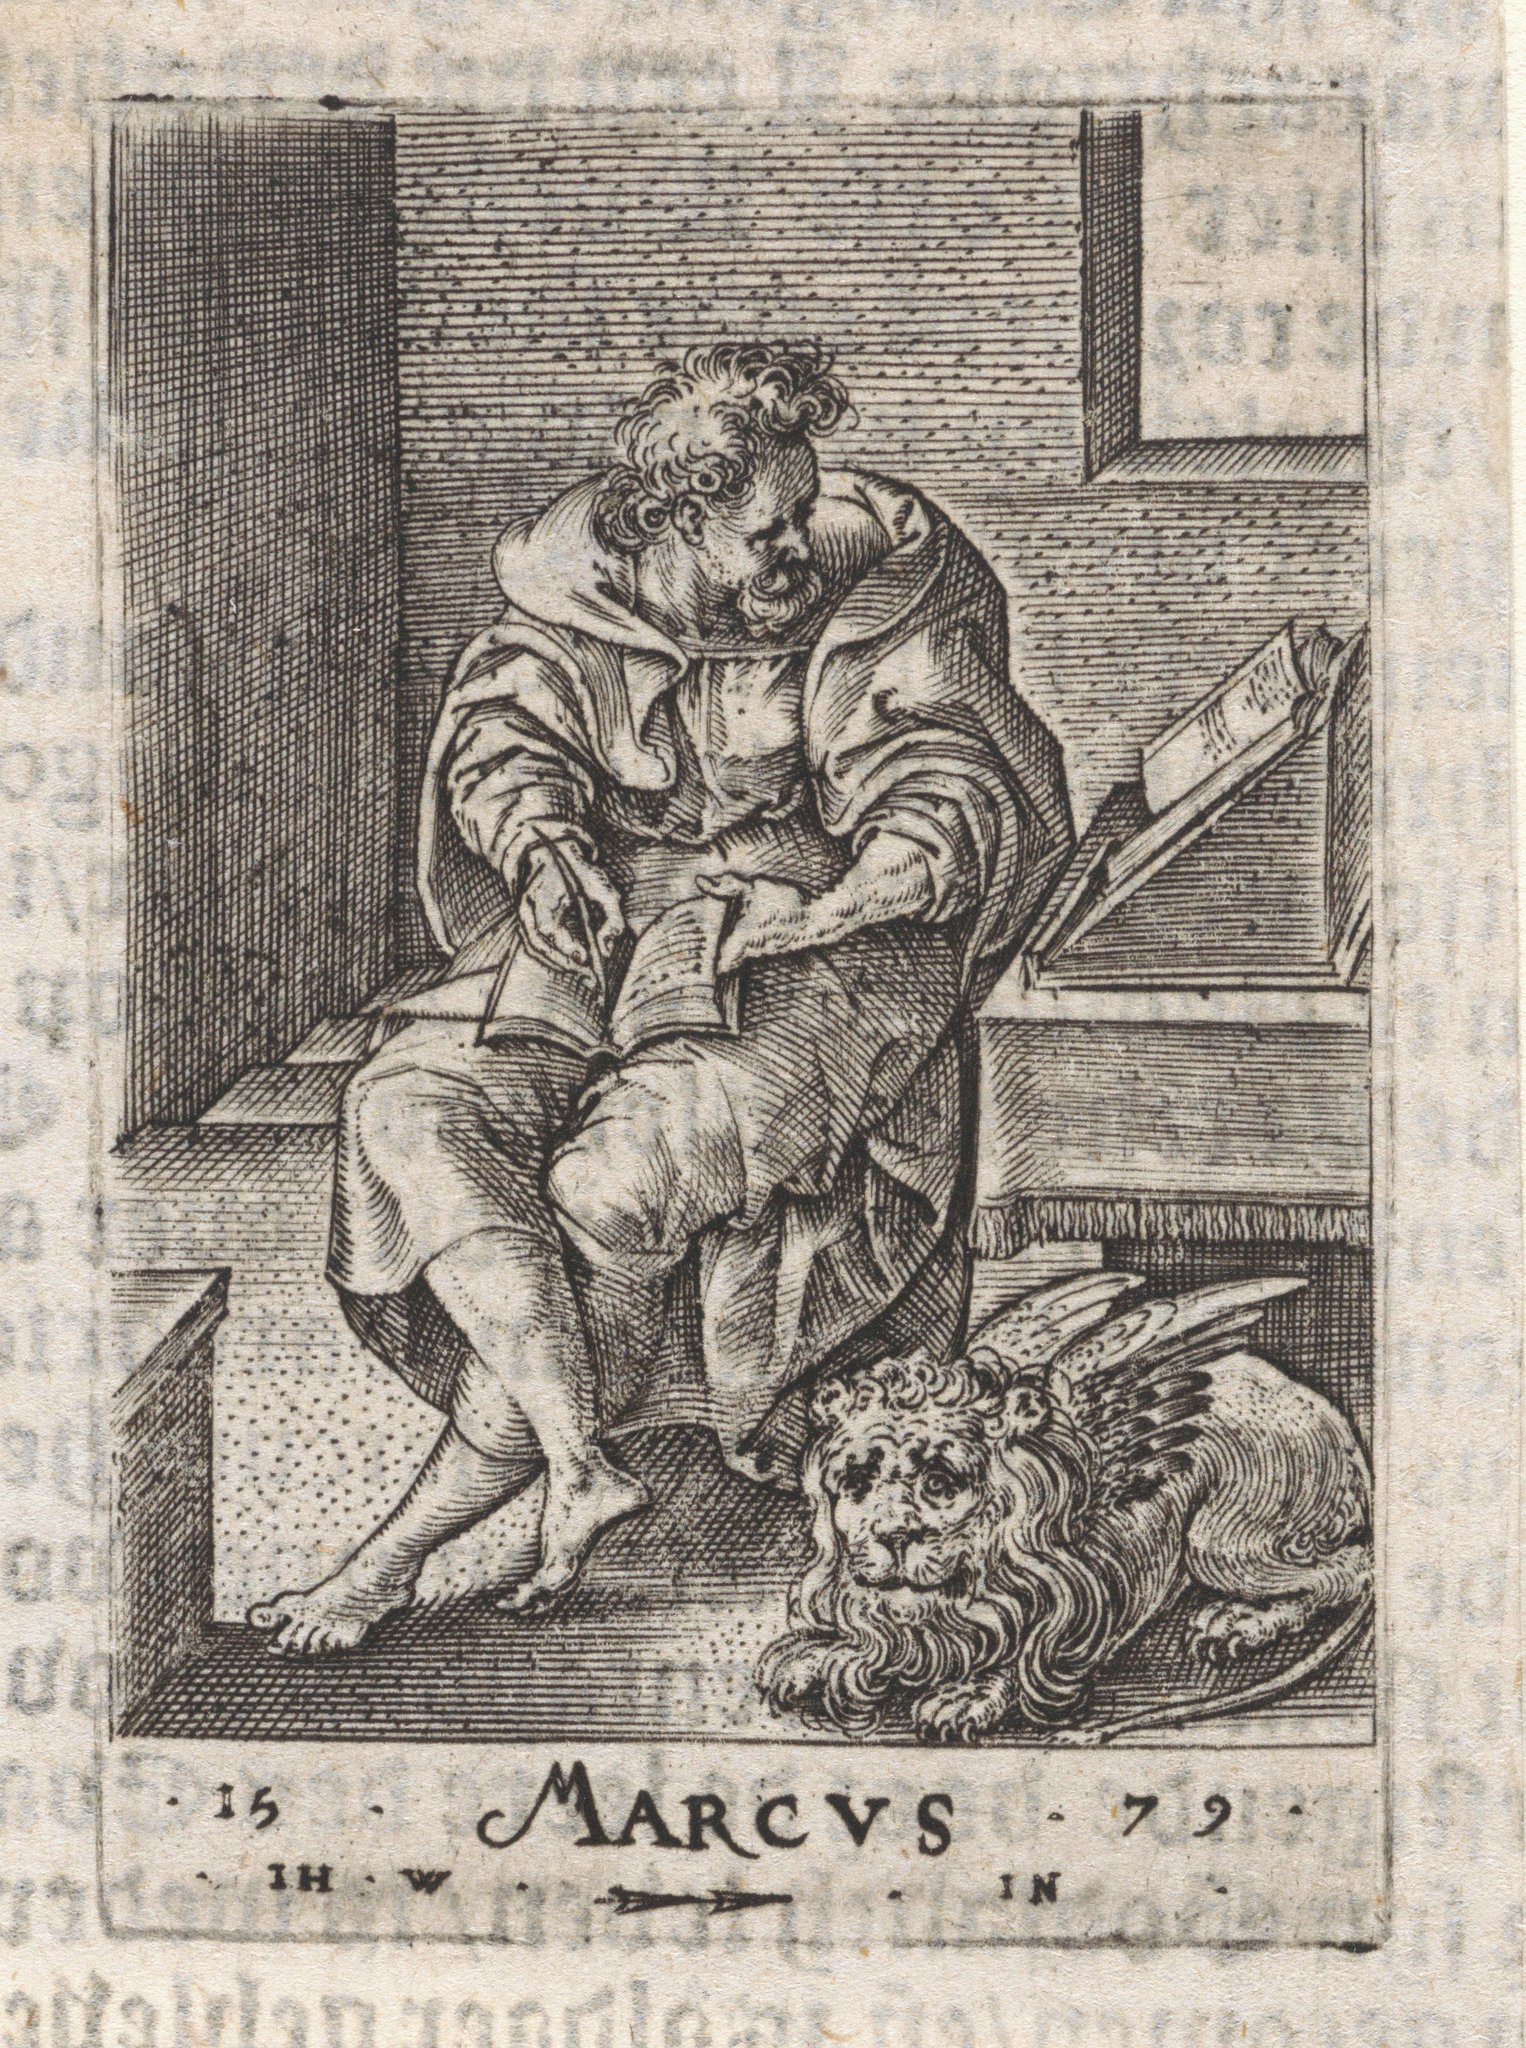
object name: book illustration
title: Vier evangelisten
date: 1579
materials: paper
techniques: engraving, letterpress printing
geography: delft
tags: st. mark the evangelist writing the gospel, usually a (winged) lion present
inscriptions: collector's mark: Lugt 2228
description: Prent gebruikt als illustratie in: Const-toonneel, inhoudende de beschrijvinghe ende XL. Heerlijcke afbeeldindinghen: Onses Heeren Jesu Christi, met sijne apostelen, ende evangelisten, midtsgaders de hooft-deuchden ende ondeuchden. Ende ten laetsten de seven planeten. In coper gesneden door Johannis Wierix. De beschrijvinge is (...). Delft: Nicolaes de Clerck, 1609.